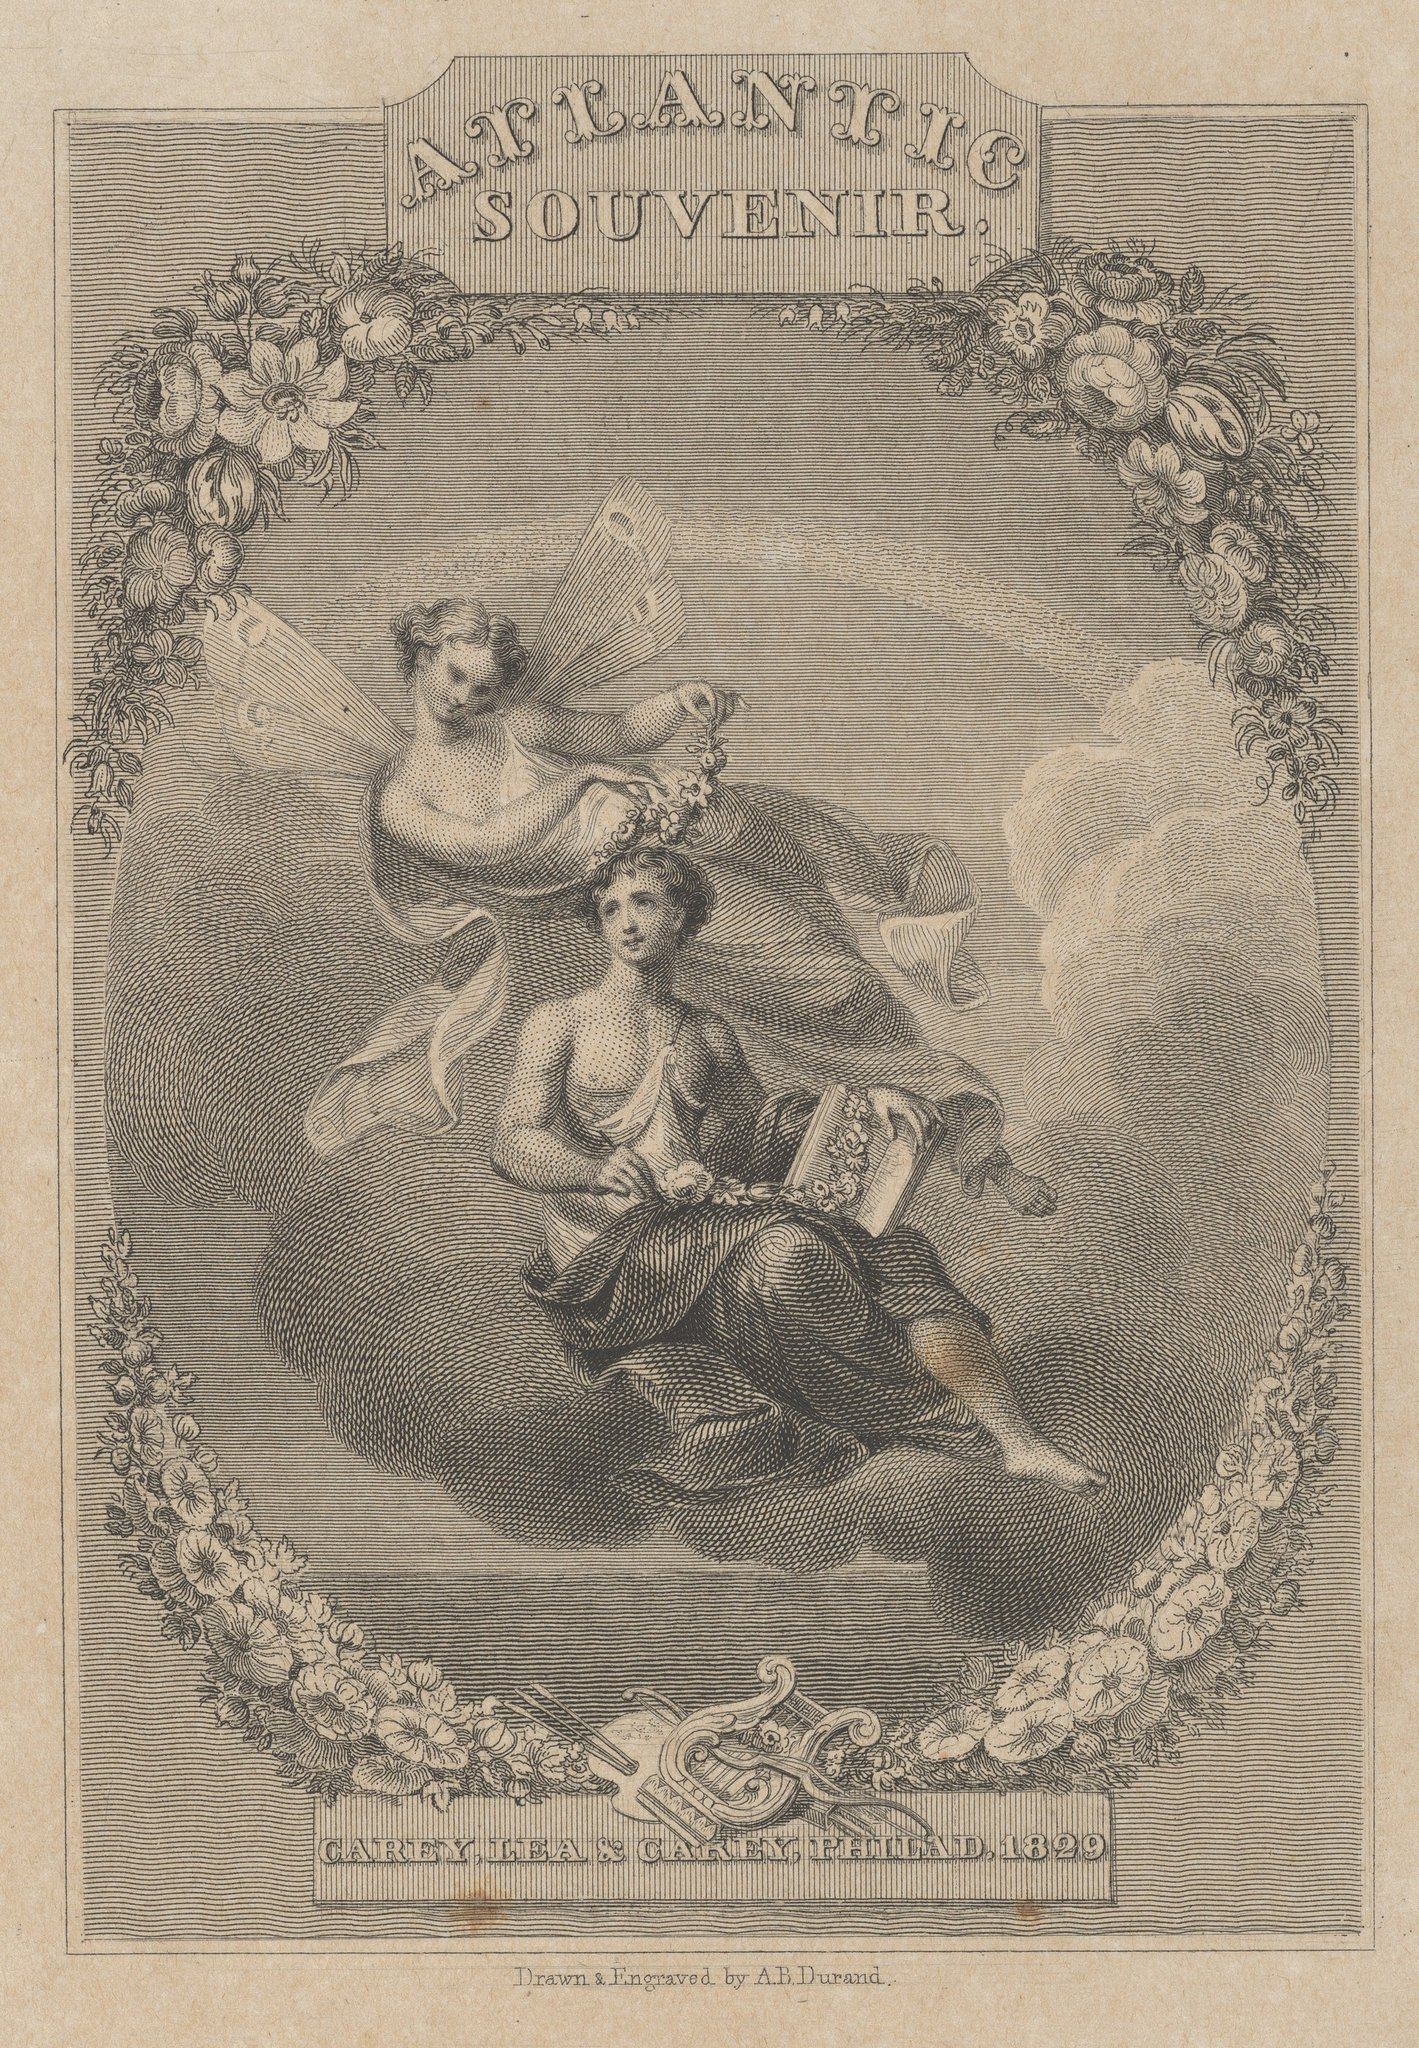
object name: print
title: Atlantic Souvenir (title page)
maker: asher brown durand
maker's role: artist and engraver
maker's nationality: american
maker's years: 1796-1886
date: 1829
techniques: engraving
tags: musical instruments,garlands,men